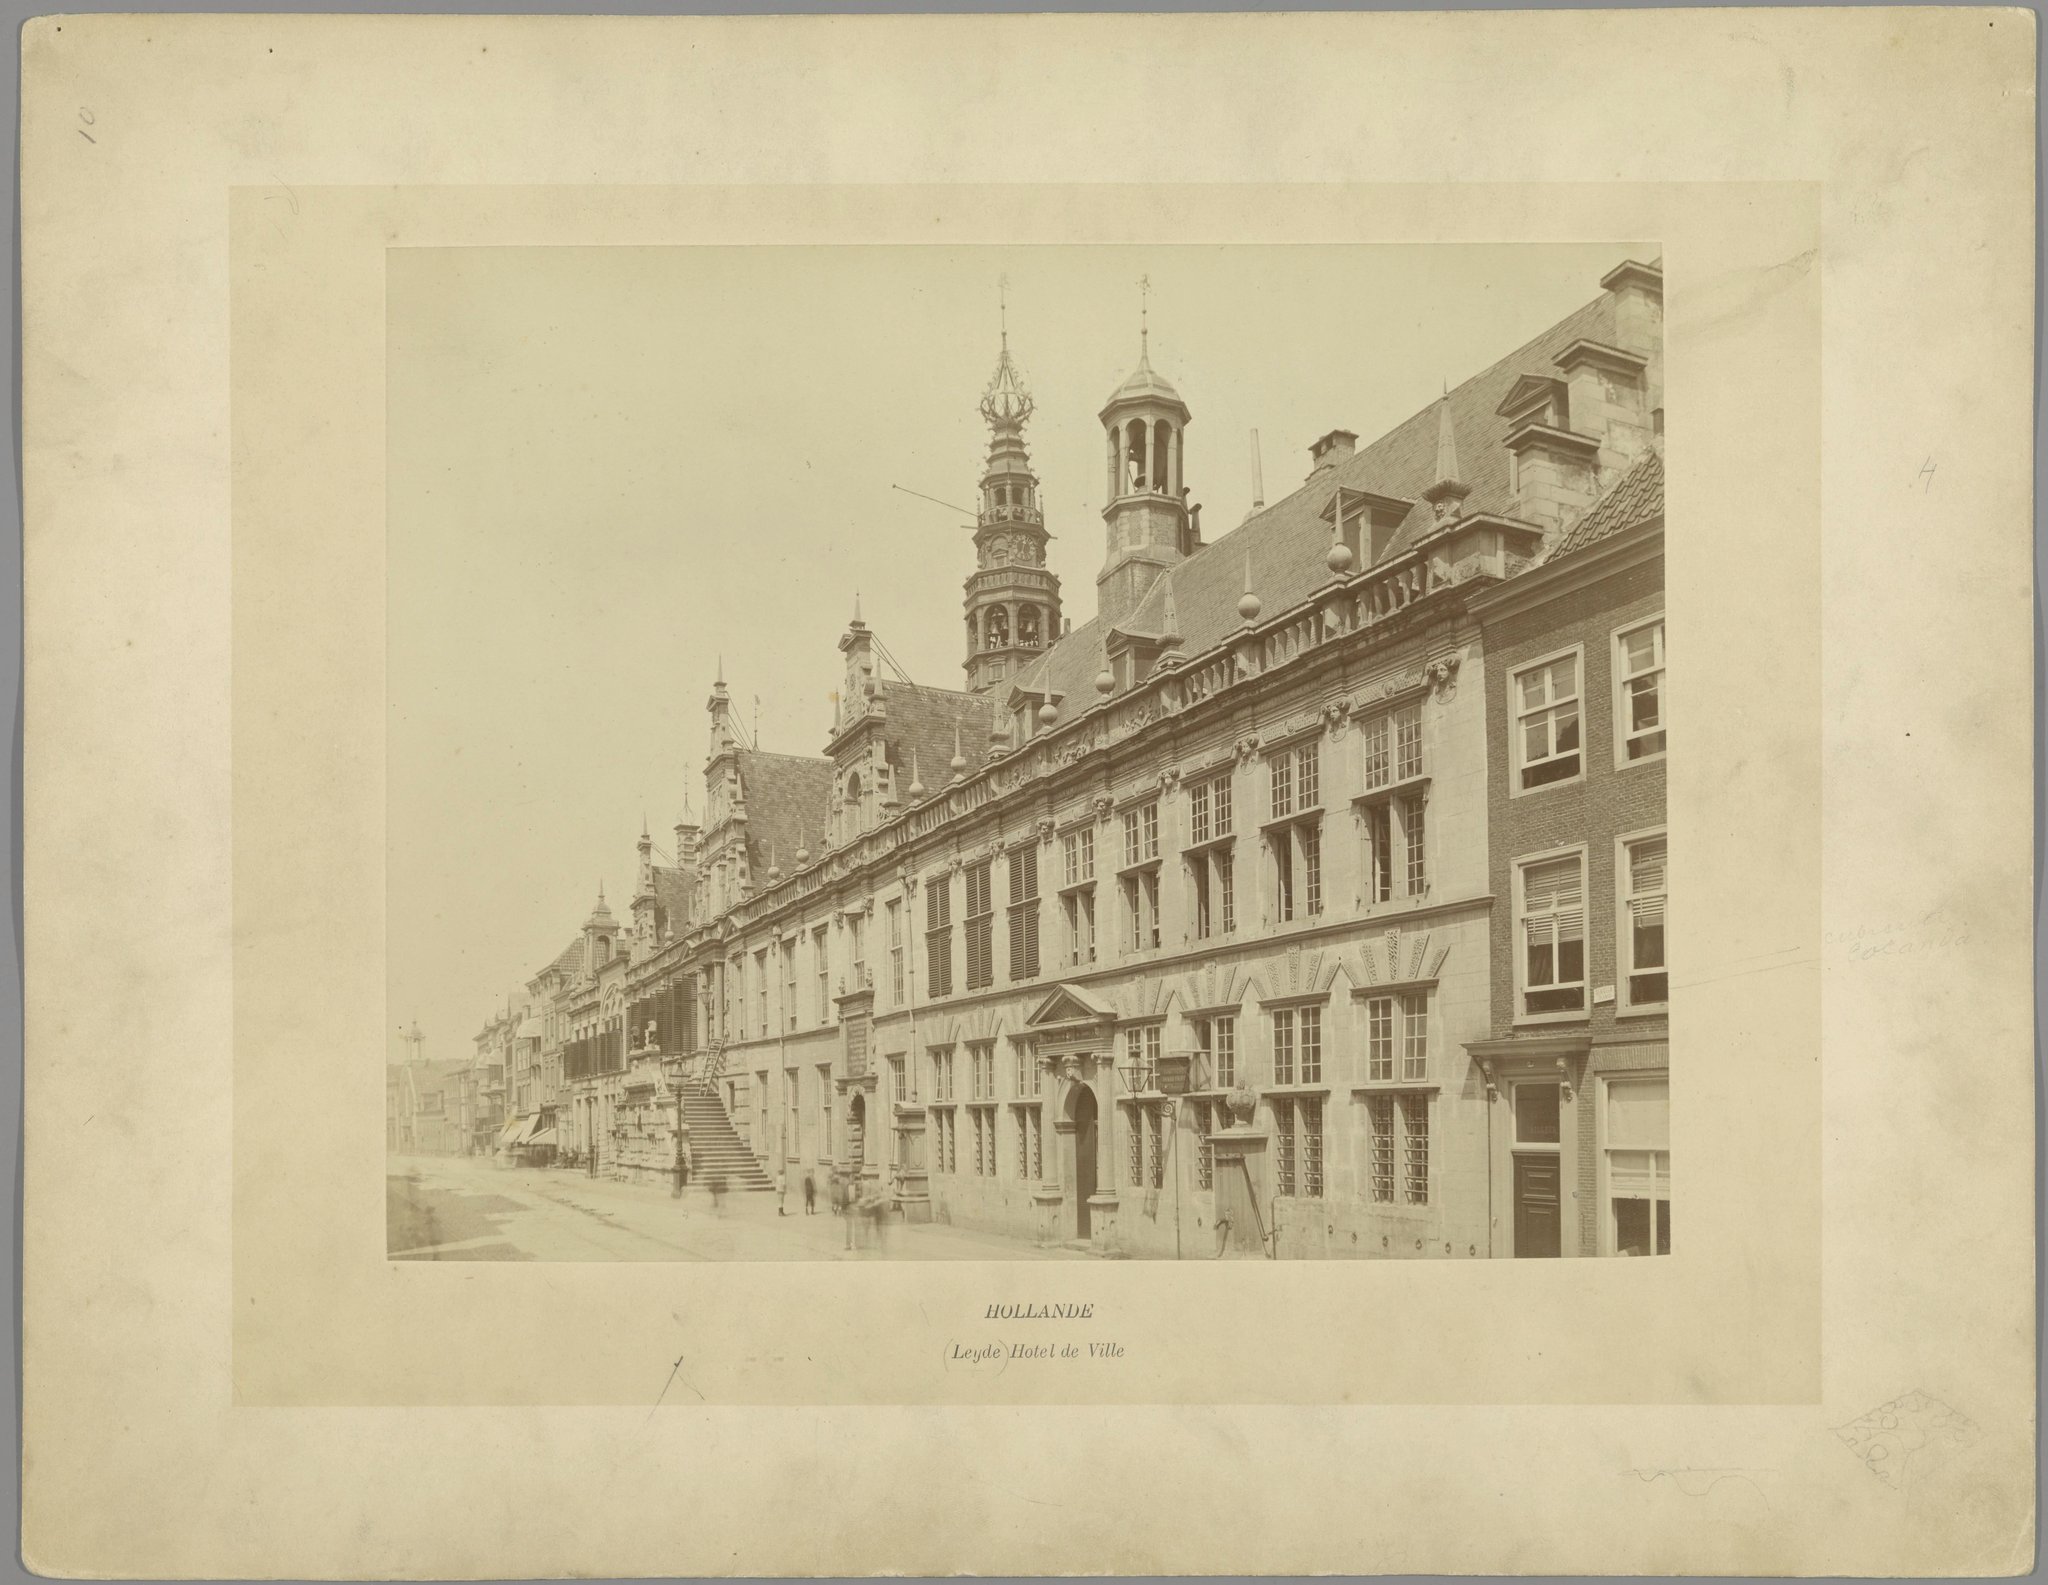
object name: photograph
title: Gezicht op het stadhuis te Leiden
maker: Anonymous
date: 1875-1900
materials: cardboard, photographic support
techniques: albumen print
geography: leiden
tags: townhall, street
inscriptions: inscription: ‘1597’, collector's mark: Lugt 3937